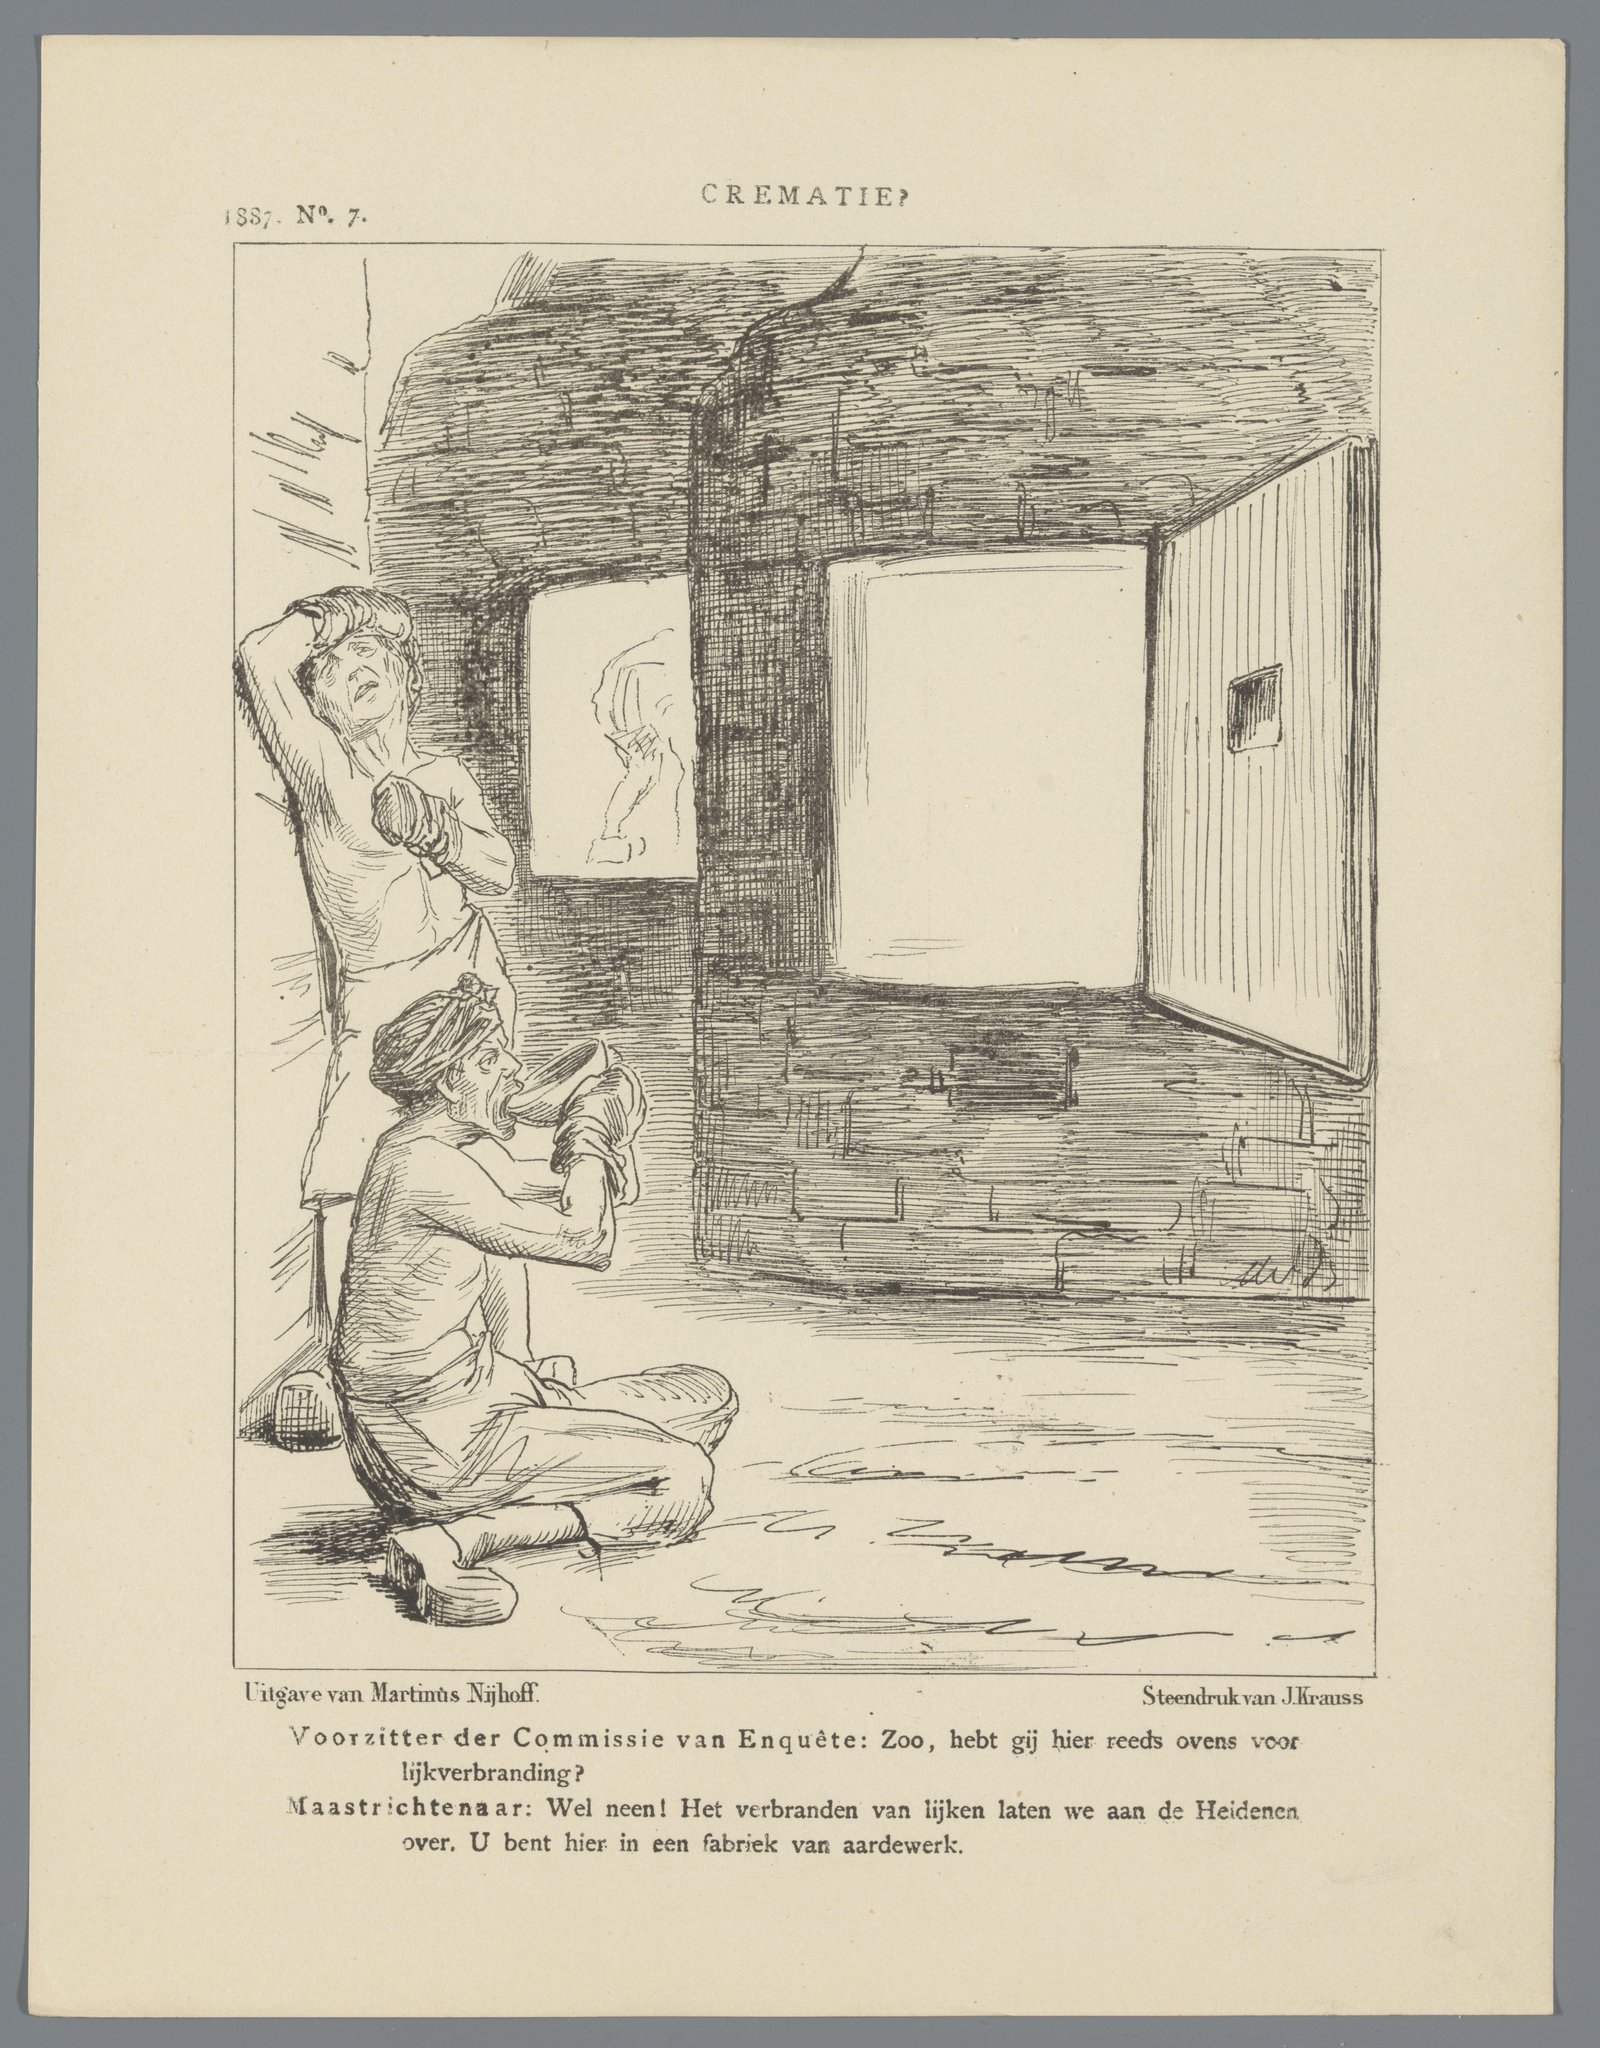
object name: cartoon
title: Spotprent over crematie en Maastricht, 1887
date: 1887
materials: paper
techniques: lithograph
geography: the hague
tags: maastricht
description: Spotprent over crematie en Maastricht. Plaat verschenen bij het weekblad De Nederlandsche Spectator, nr. 7, 1887.